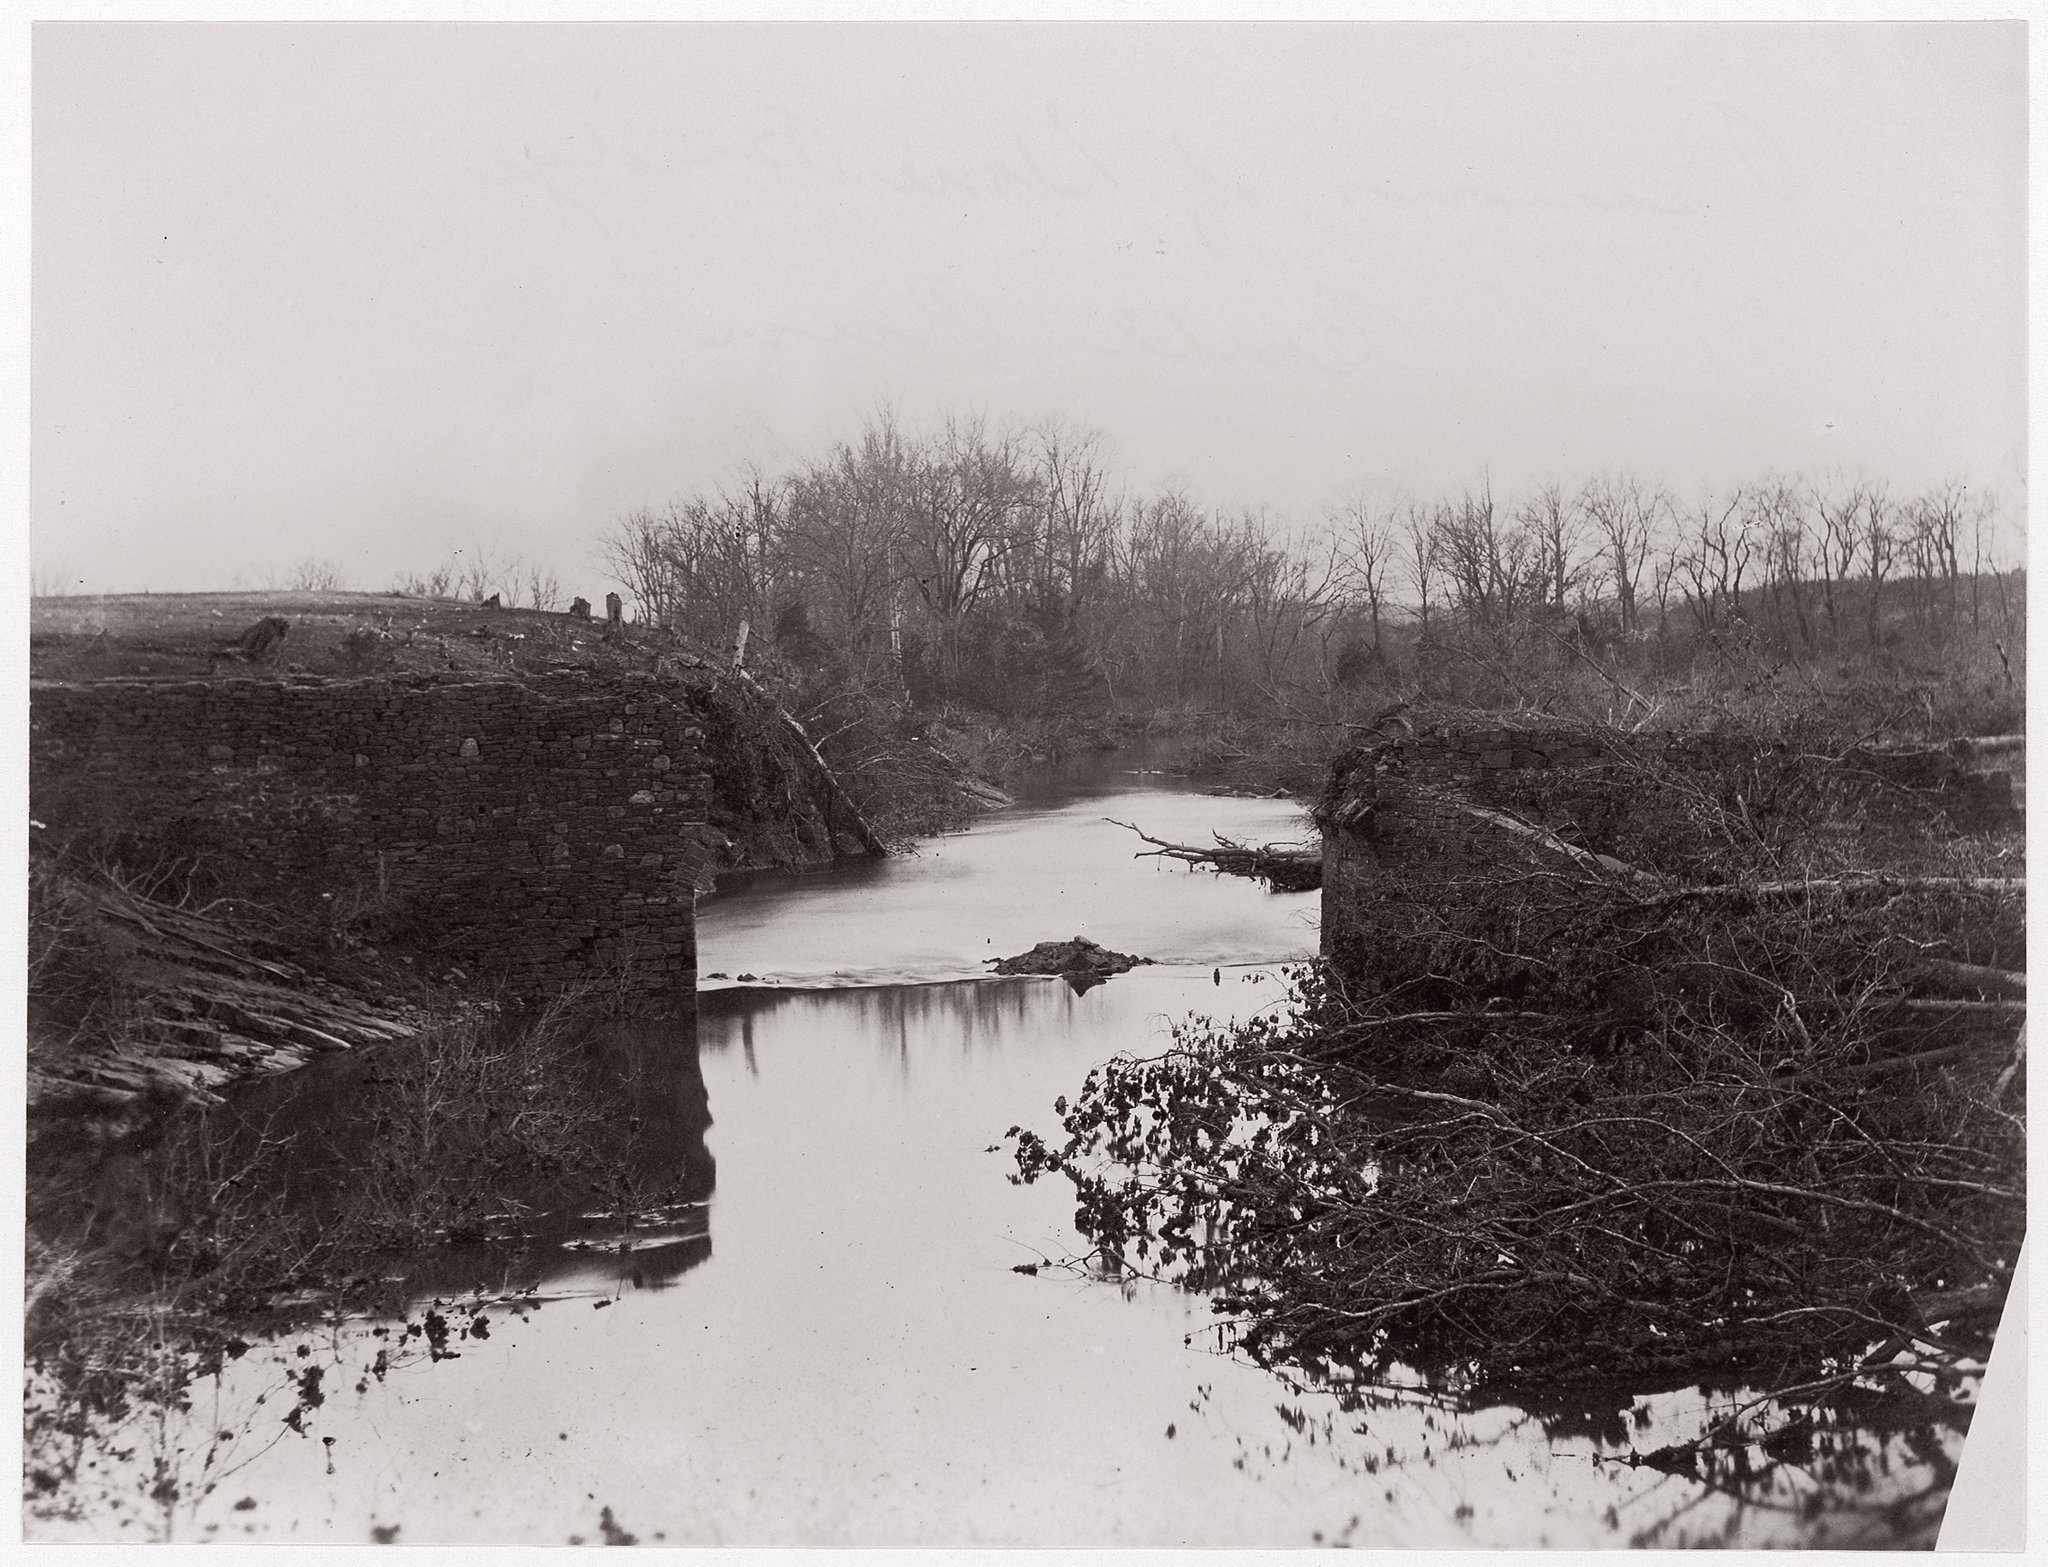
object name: photograph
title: Bull Run. The Stone Bridge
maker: timothy h. o'sullivan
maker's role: artist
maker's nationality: american, born ireland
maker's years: 1840-1882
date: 1861-1862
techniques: albumen silver print, glass negative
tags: bridges,american civil war